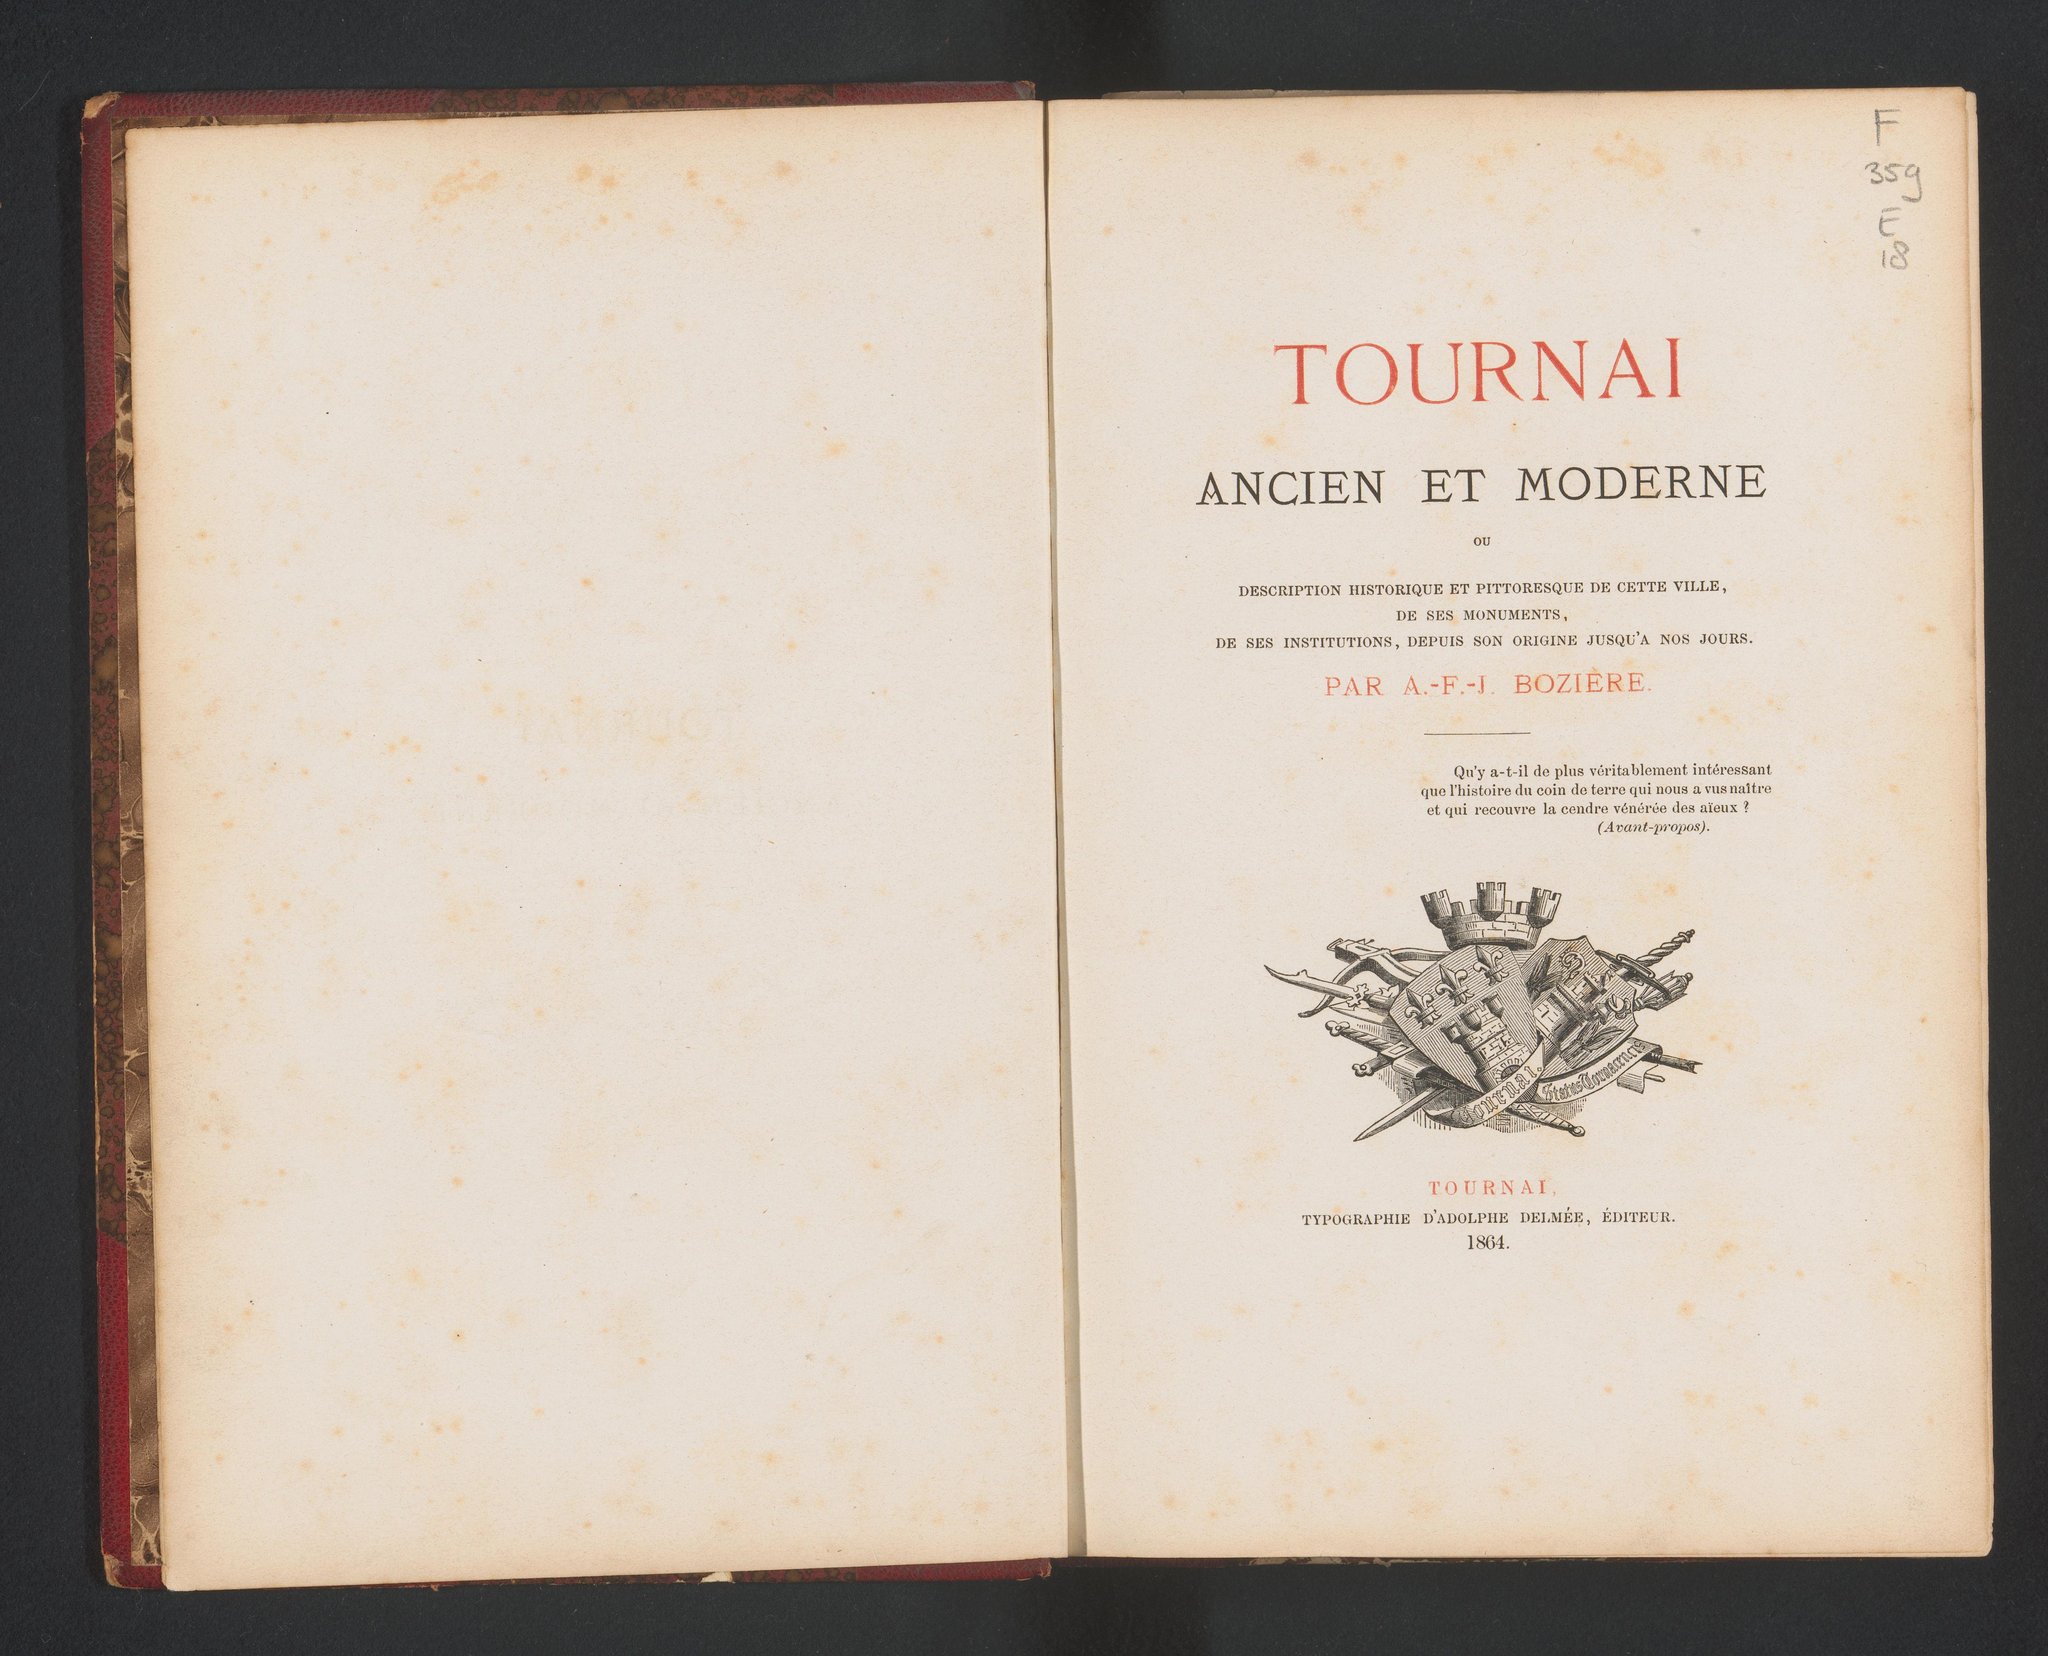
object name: book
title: Tournai ancien et moderne : ou, Desciption historique et pittoresque de cette ville, de ses monuments, des ses institutions, depuis son origine jusqu'a nos jours / par A.-F.-J. Bozière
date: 1864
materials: cardboard, leather, linen, paper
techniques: marbled paper, lithograph, photolithography, printing, printing block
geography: doornik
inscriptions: annotation: ‘NOV/ 1987’